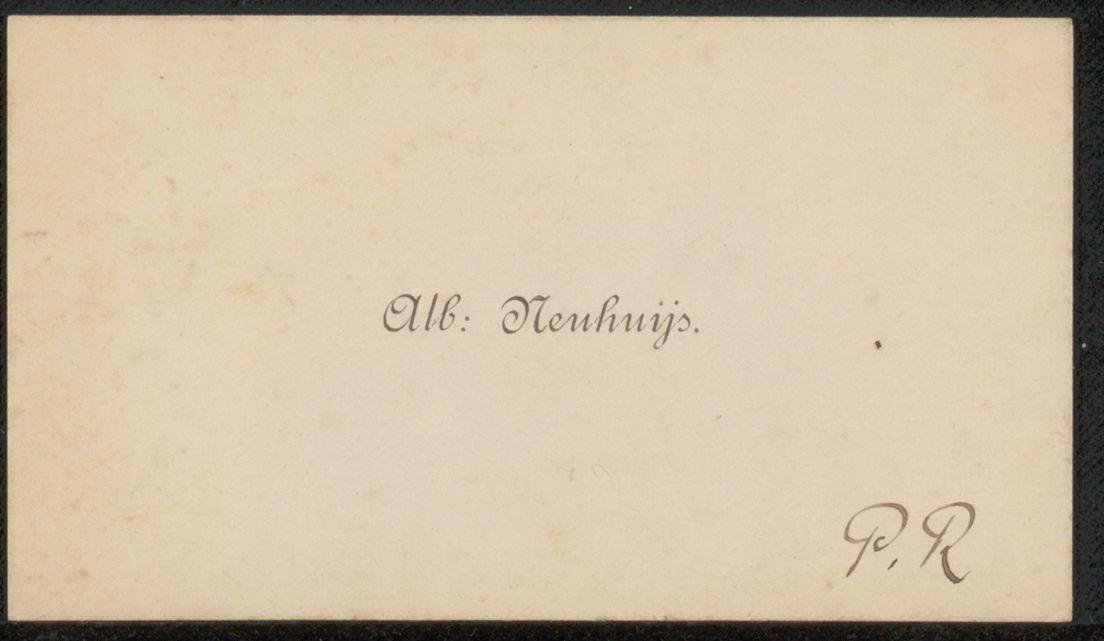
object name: visiting card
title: Visitekaartje aan Philip Zilcken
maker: albert neuhuys (1844-1914)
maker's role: draughtsman, painter, print maker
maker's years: 1844-1914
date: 1854-1914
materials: cardboard, ink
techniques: pen, printing, writing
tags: the hague, painter, draughtsman, philip zilcken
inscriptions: collector's mark: ‘RPK’